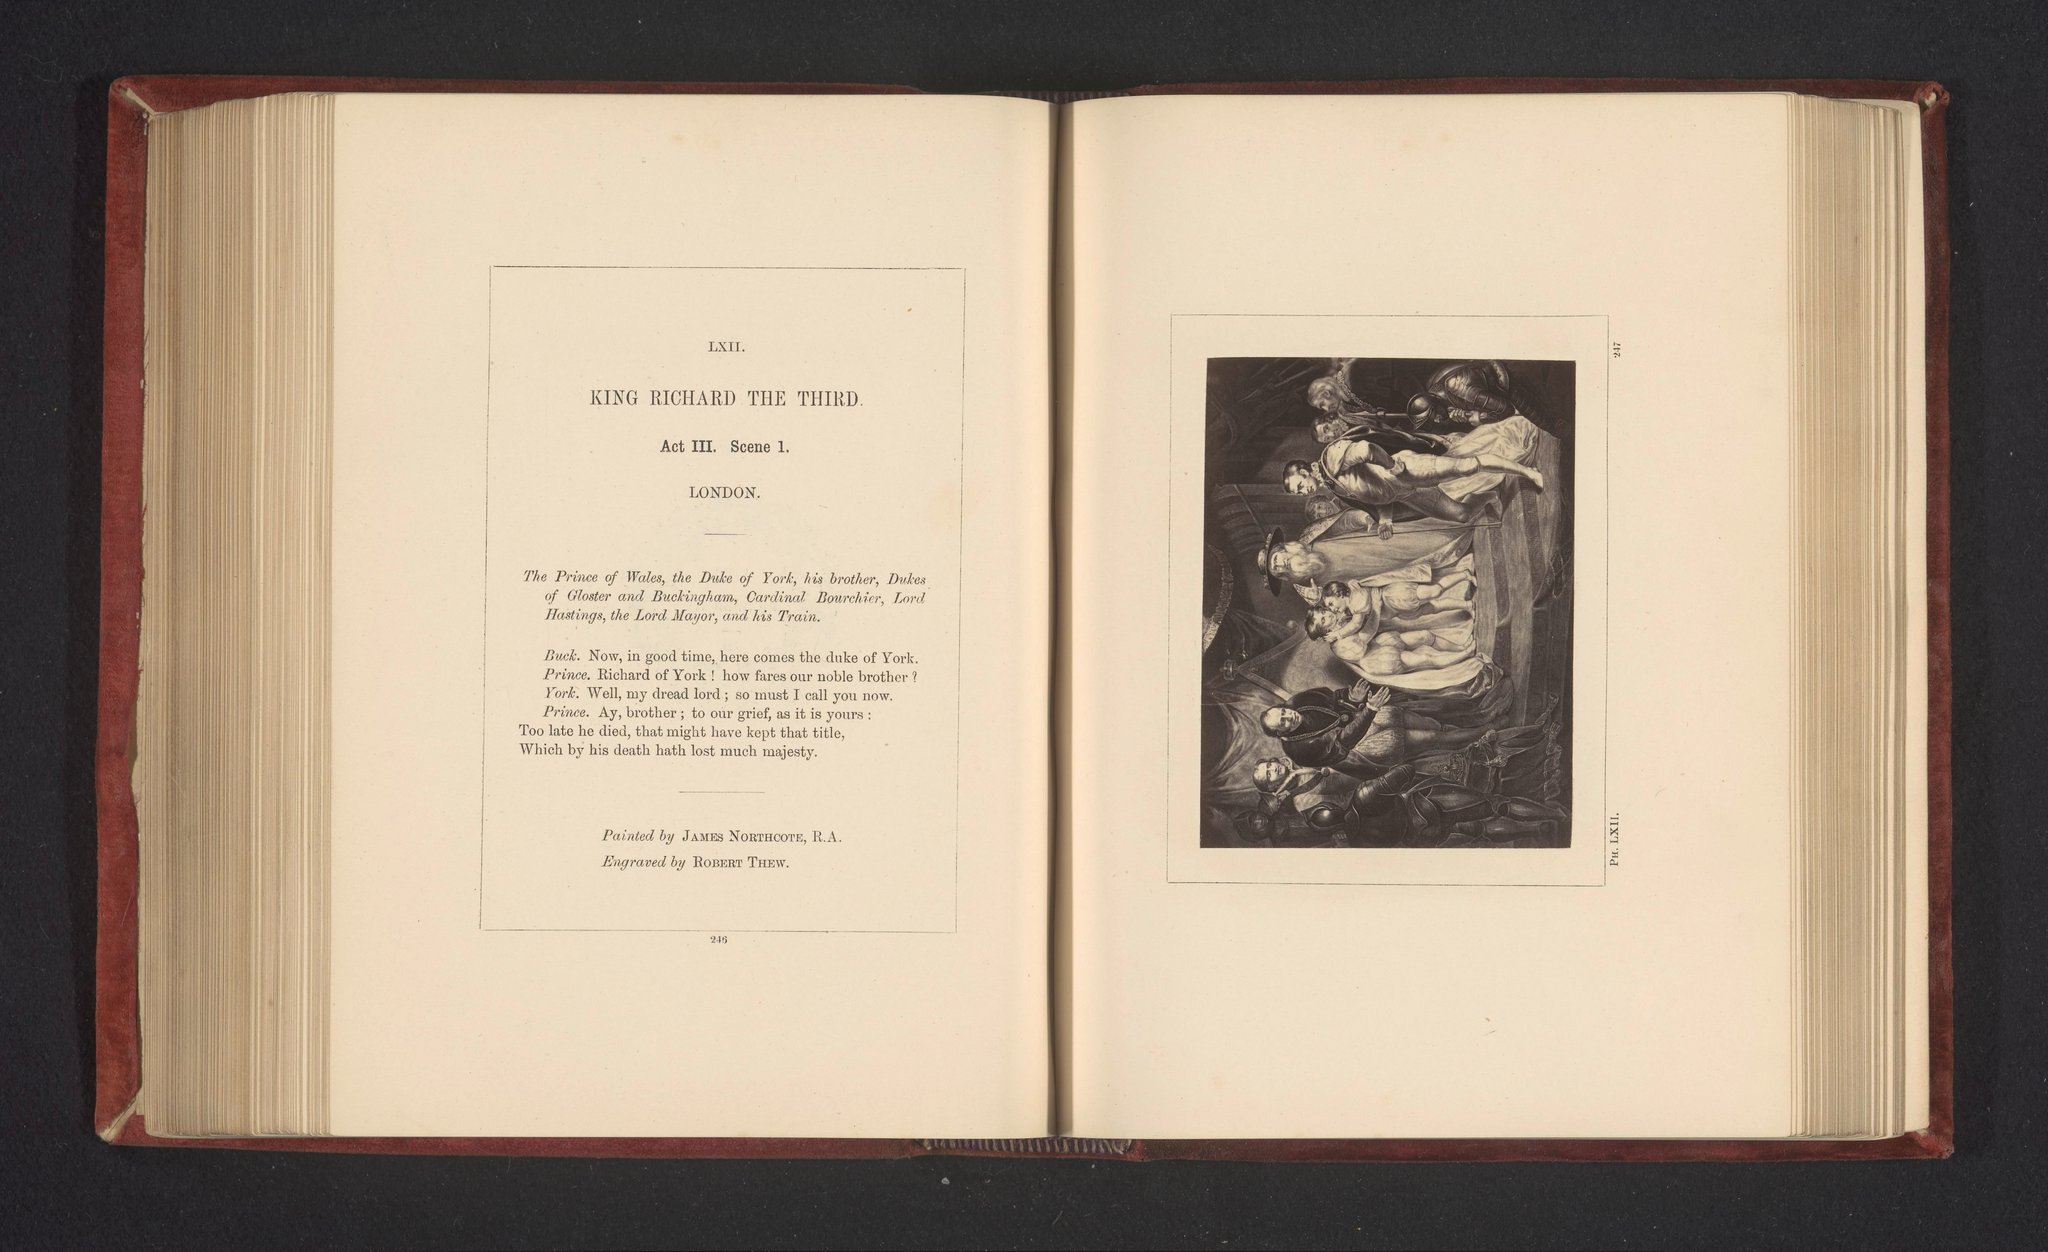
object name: photograph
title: Fotoreproductie van een prent naar een schilderij door James Northcote, voorstellend een scene uit Richard III door William Shakespeare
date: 1854-1864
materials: photographic support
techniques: albumen print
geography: london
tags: specific works of literature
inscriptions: number: ‘Ph. LXII. 247’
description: Te zien is akte III, scene 1 met een gezelschap in een paleis in Londen.